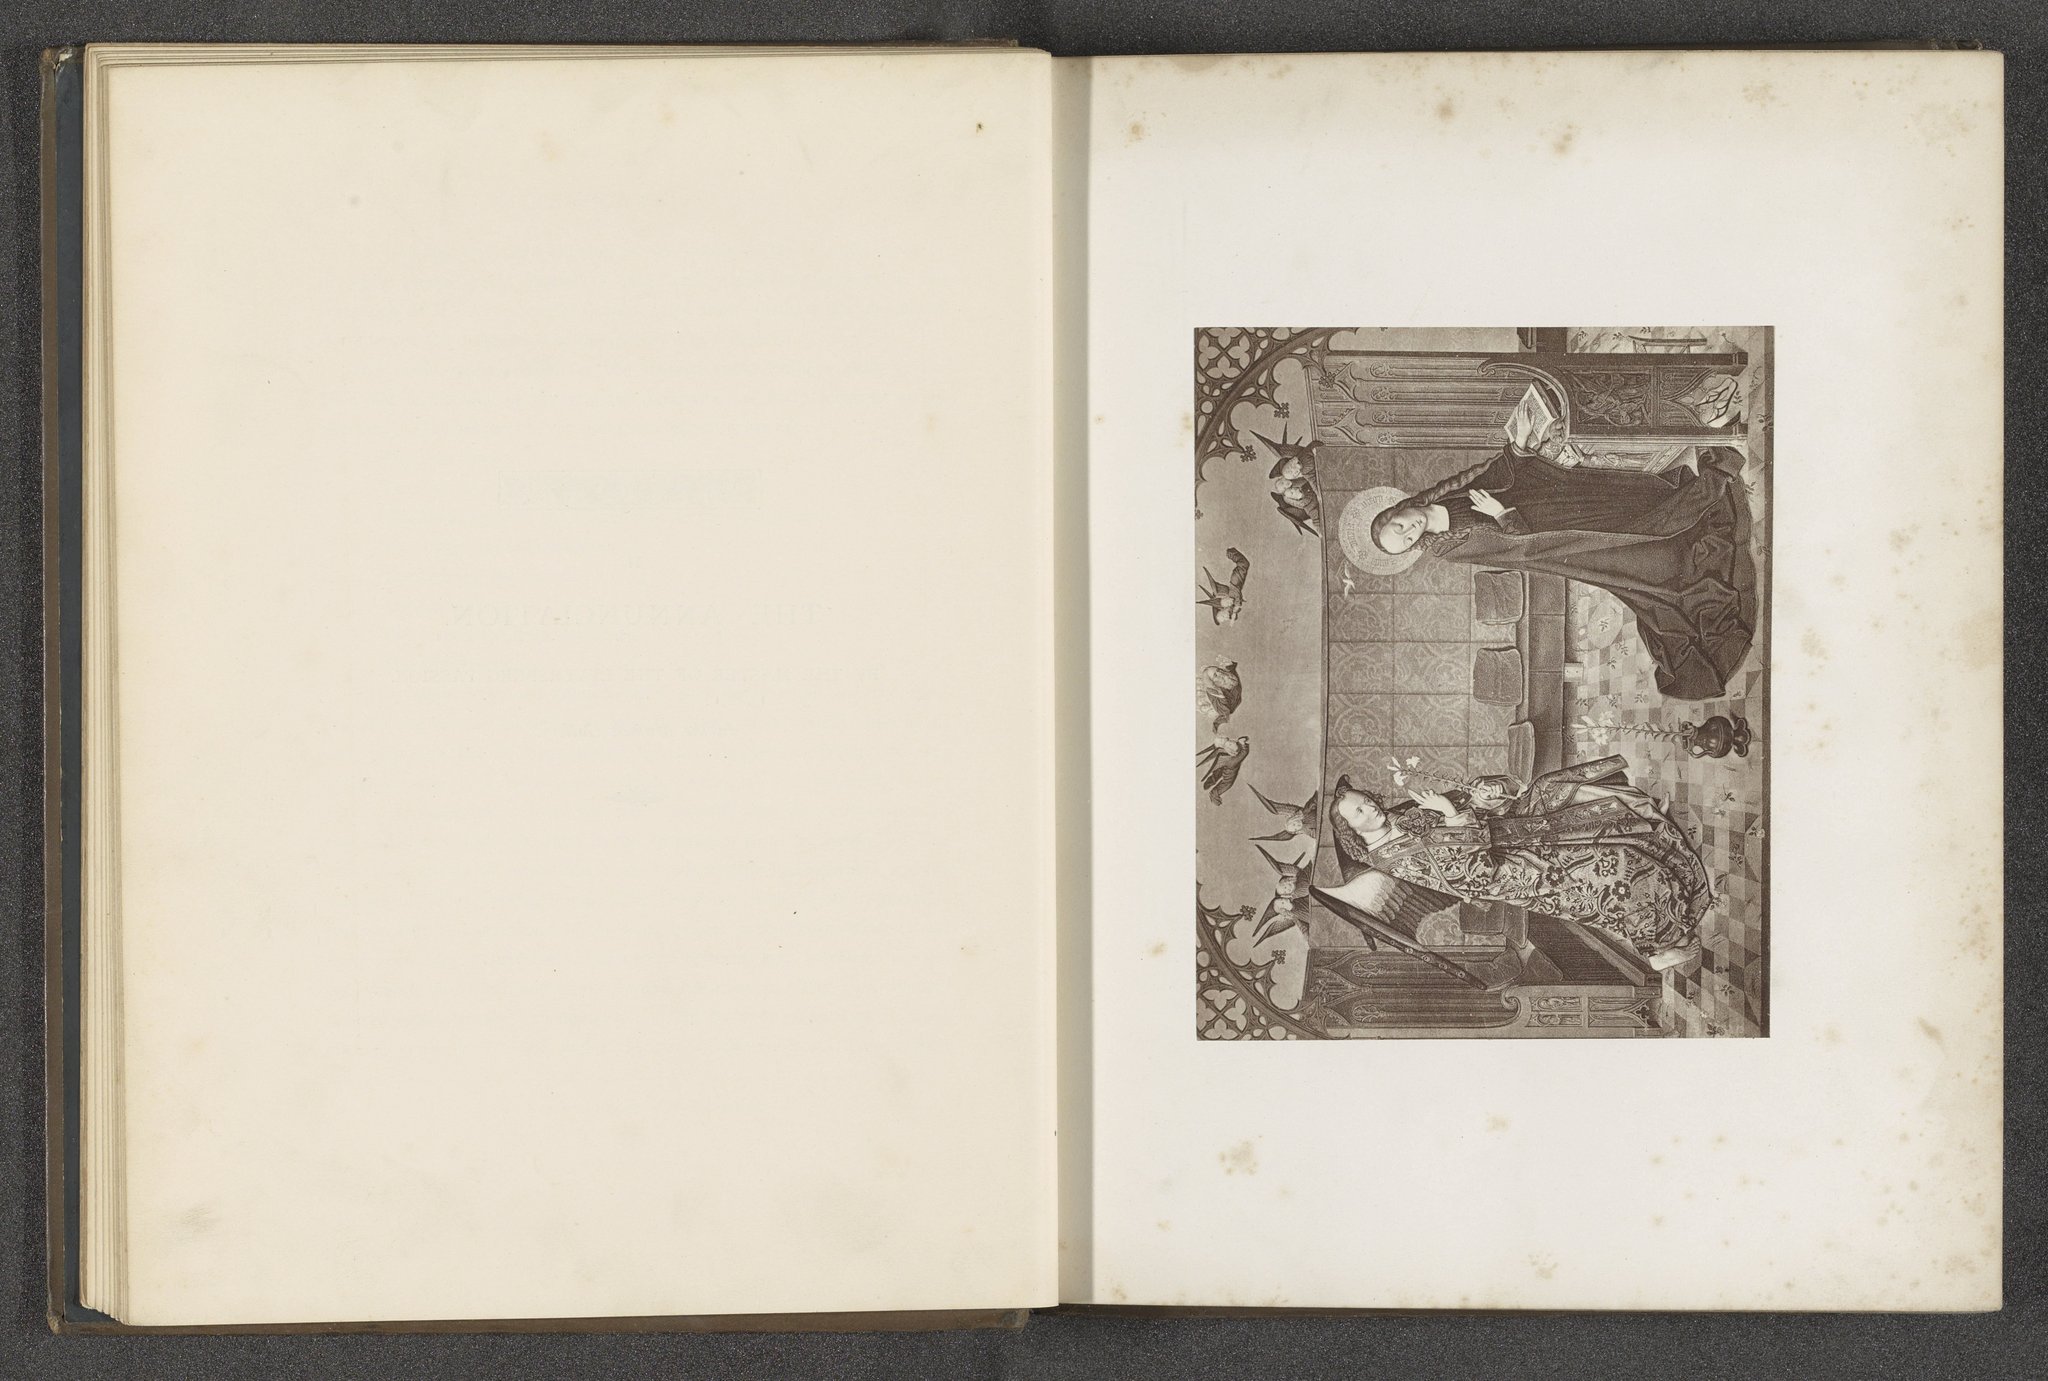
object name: photomechanical print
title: Fotoreproductie van een prent naar een schilderij, voorstellende de Annunciatie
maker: Anonymous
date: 1859-1869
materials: paper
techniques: woodburytype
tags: the annunciation: mary kneeling